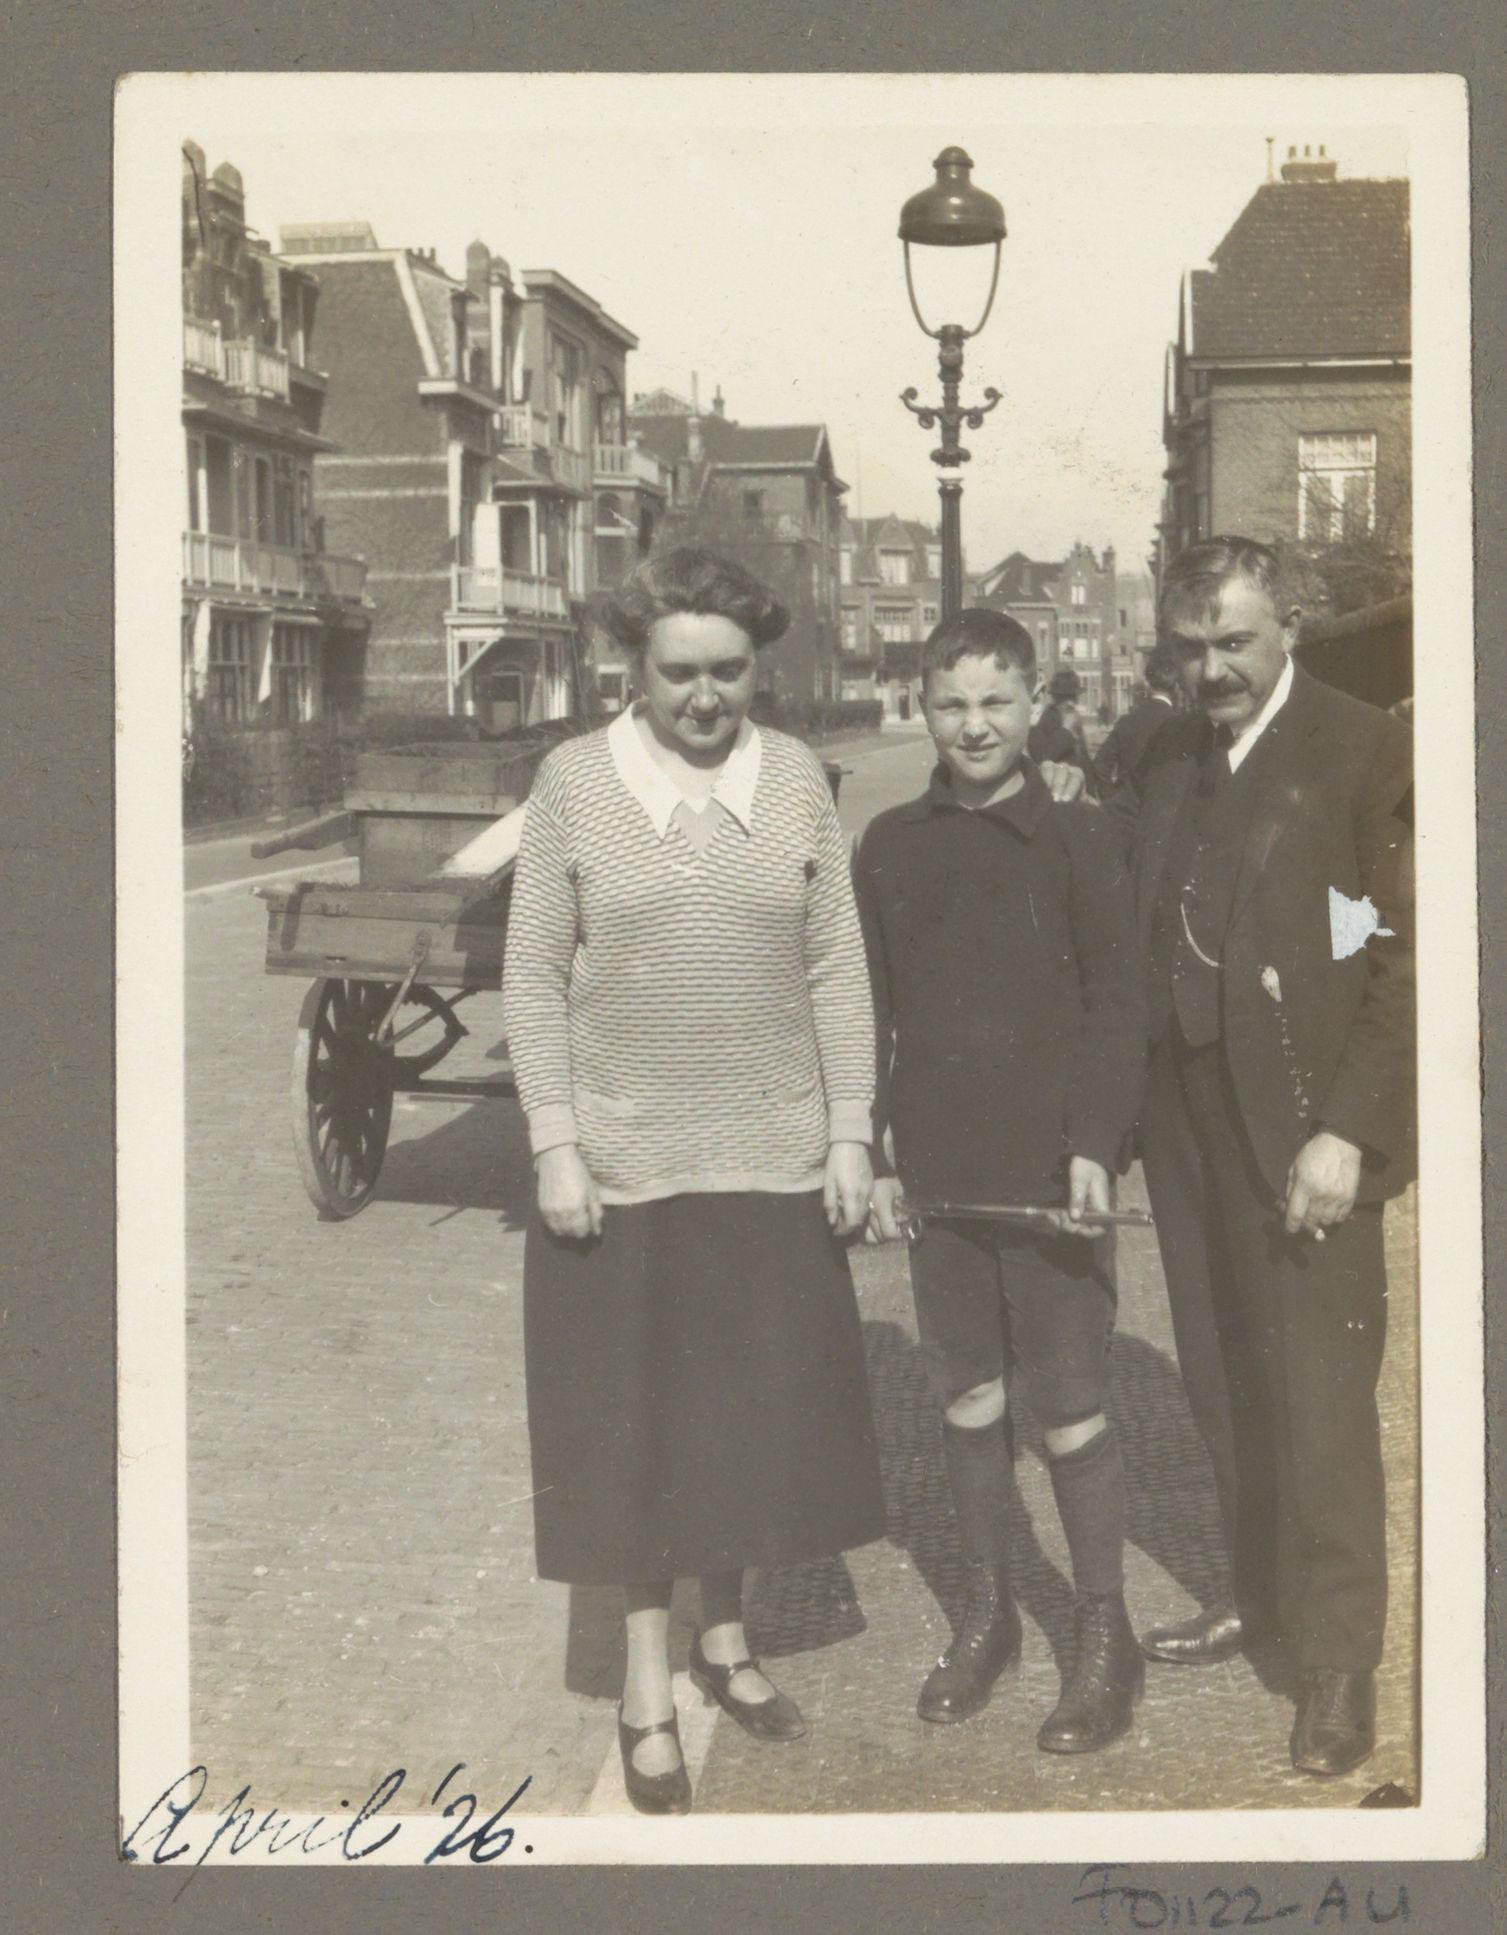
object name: photograph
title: Man, vrouw en (vermoedelijk) Georges Bergsma op straat in Nederland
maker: Anonymous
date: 1904-1926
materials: photographic support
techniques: gelatin silver print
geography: netherlands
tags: utrecht, parents with their children, street (+ city(-scape) with figures, staffage), netherlands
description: Onderdeel van fotoalbum met opnames van de familie Bergsma in Tandjong Poera en Rantan Pandjang (Sumatra).